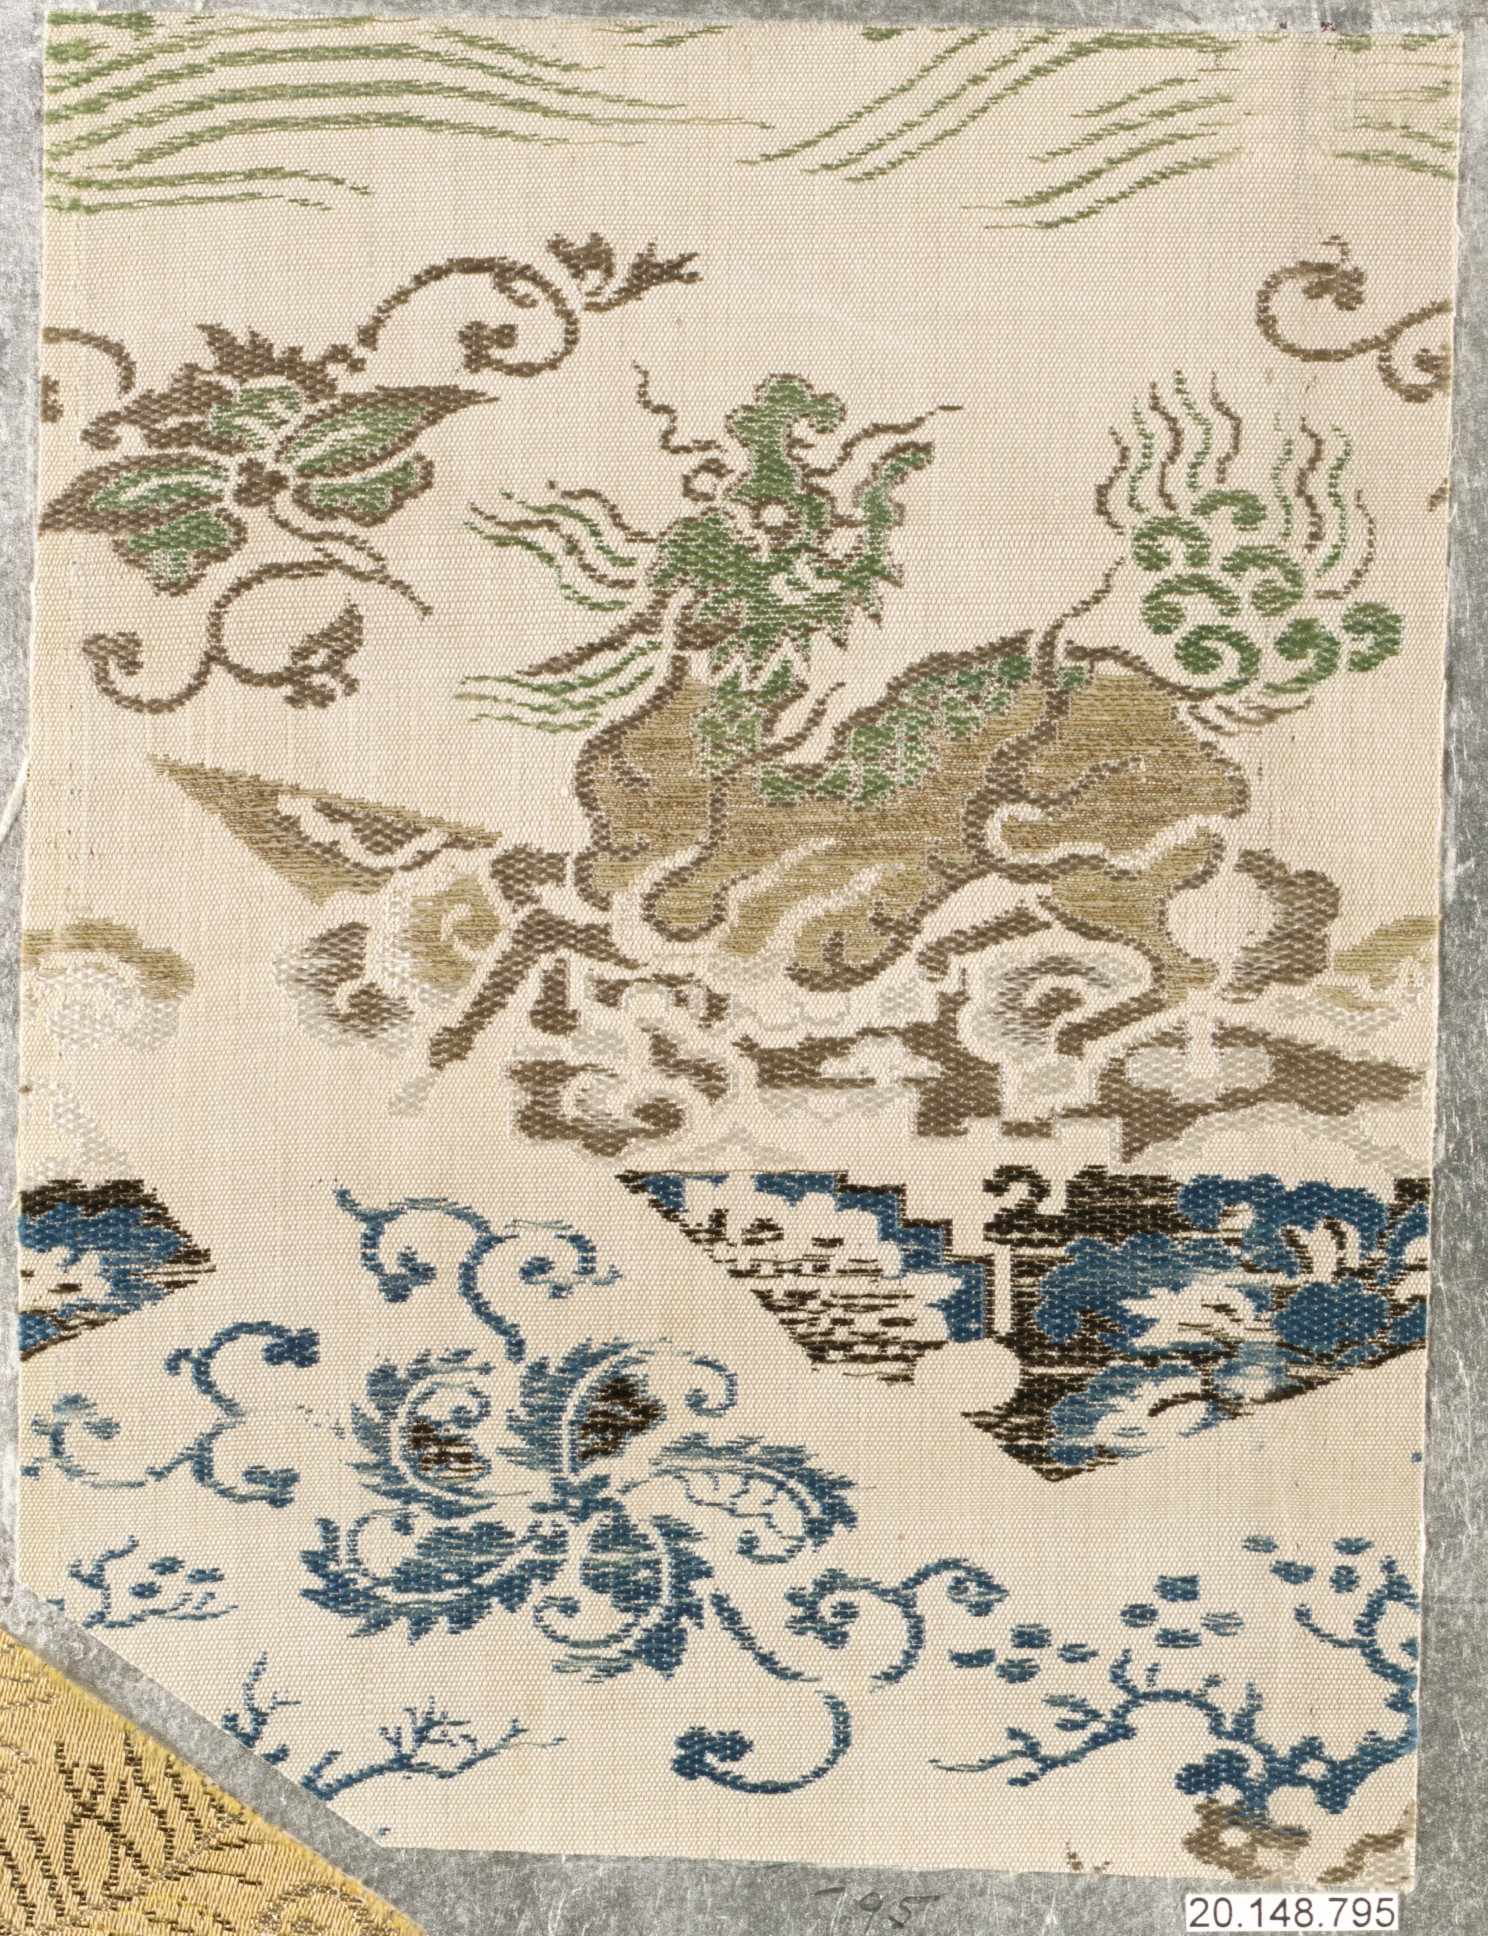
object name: piece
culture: japanese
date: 1701-1800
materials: silk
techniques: compound weave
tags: flowers